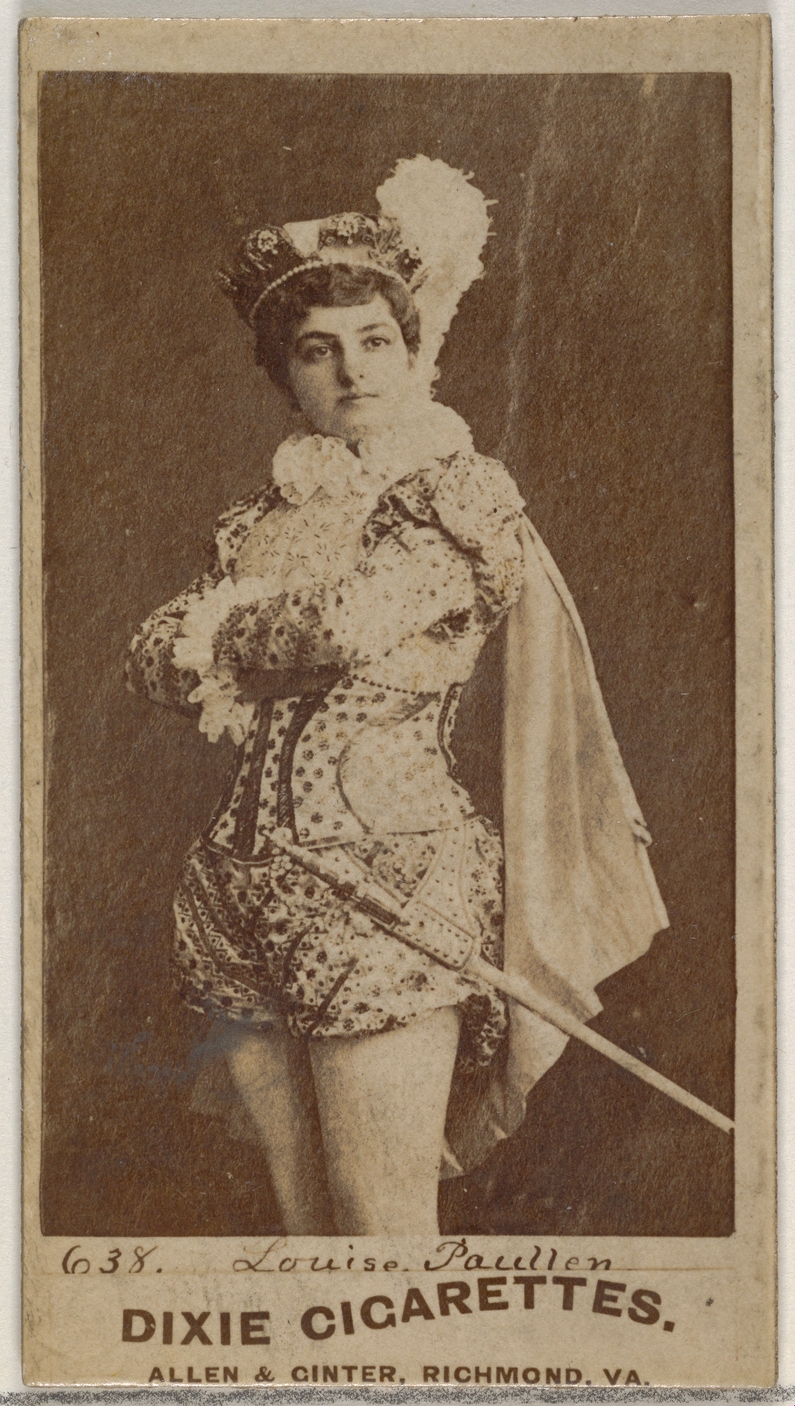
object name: photograph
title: Card 638, Louise Paullin, from the Actors and Actresses series (N45, Type 7) for Dixie Cigarettes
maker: allen & ginter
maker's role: publisher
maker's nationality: american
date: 1888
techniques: albumen silver print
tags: swords,portraits,women,actresses